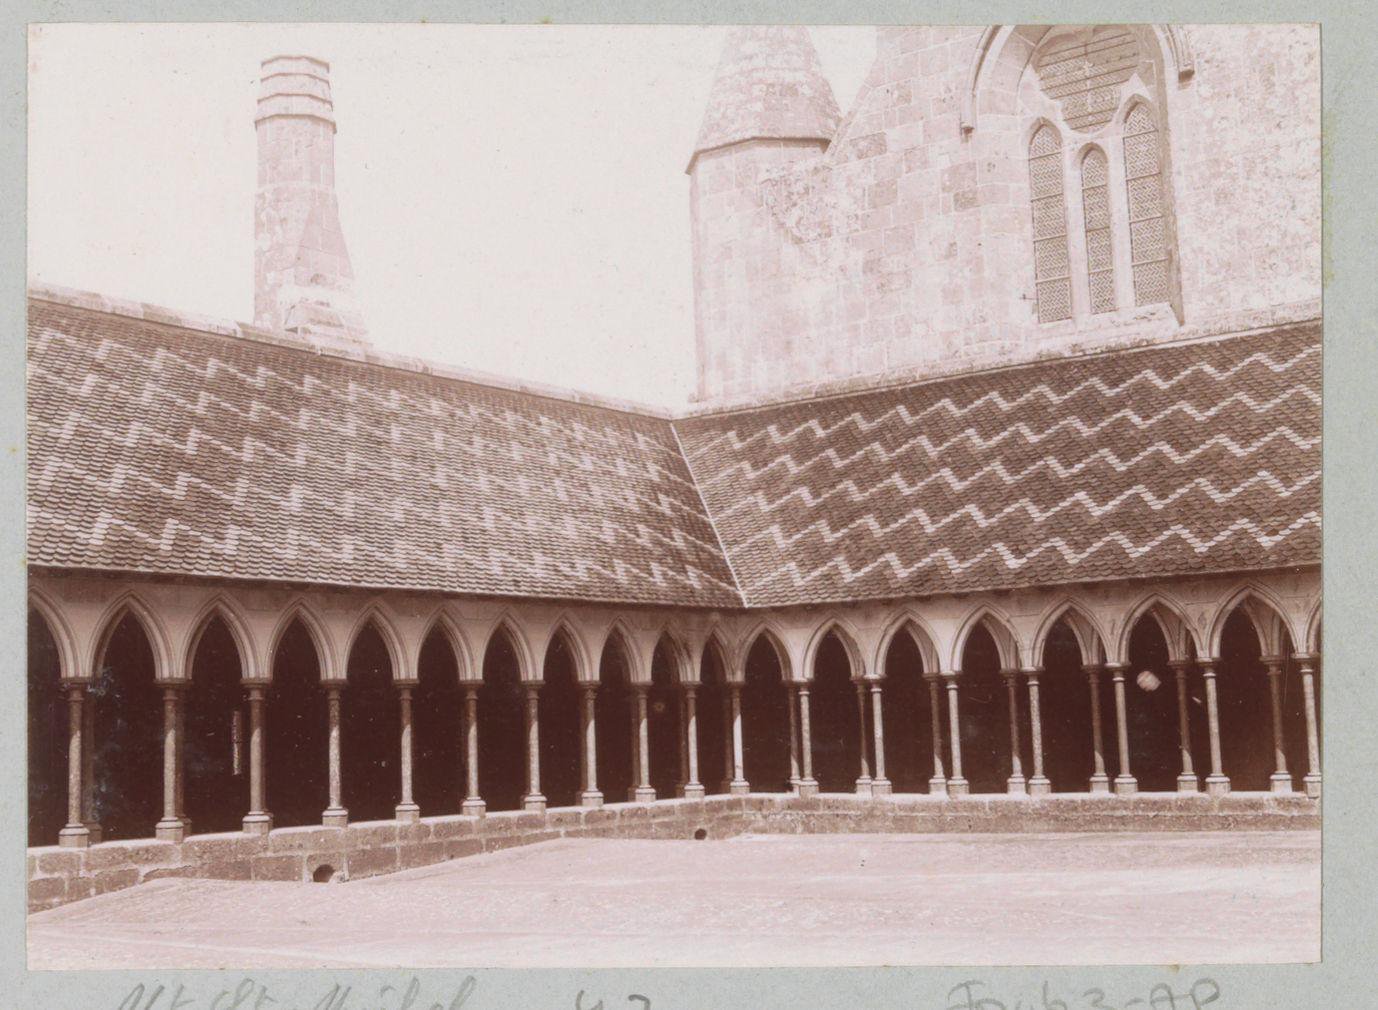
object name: photograph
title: Kloostergang op Mont-Saint-Michel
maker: delizy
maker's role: manufacturer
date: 1808-1896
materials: paper, photographic support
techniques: gelatin silver print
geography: mont-saint-michel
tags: colonnade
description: Onderdeel van Fotoalbum van een Franse amateurfotograaf met opnames van uitstapjes in Frankrijk, Spanje, België, Luxemburg en Nederland, de eerste automobielen en autoraces.